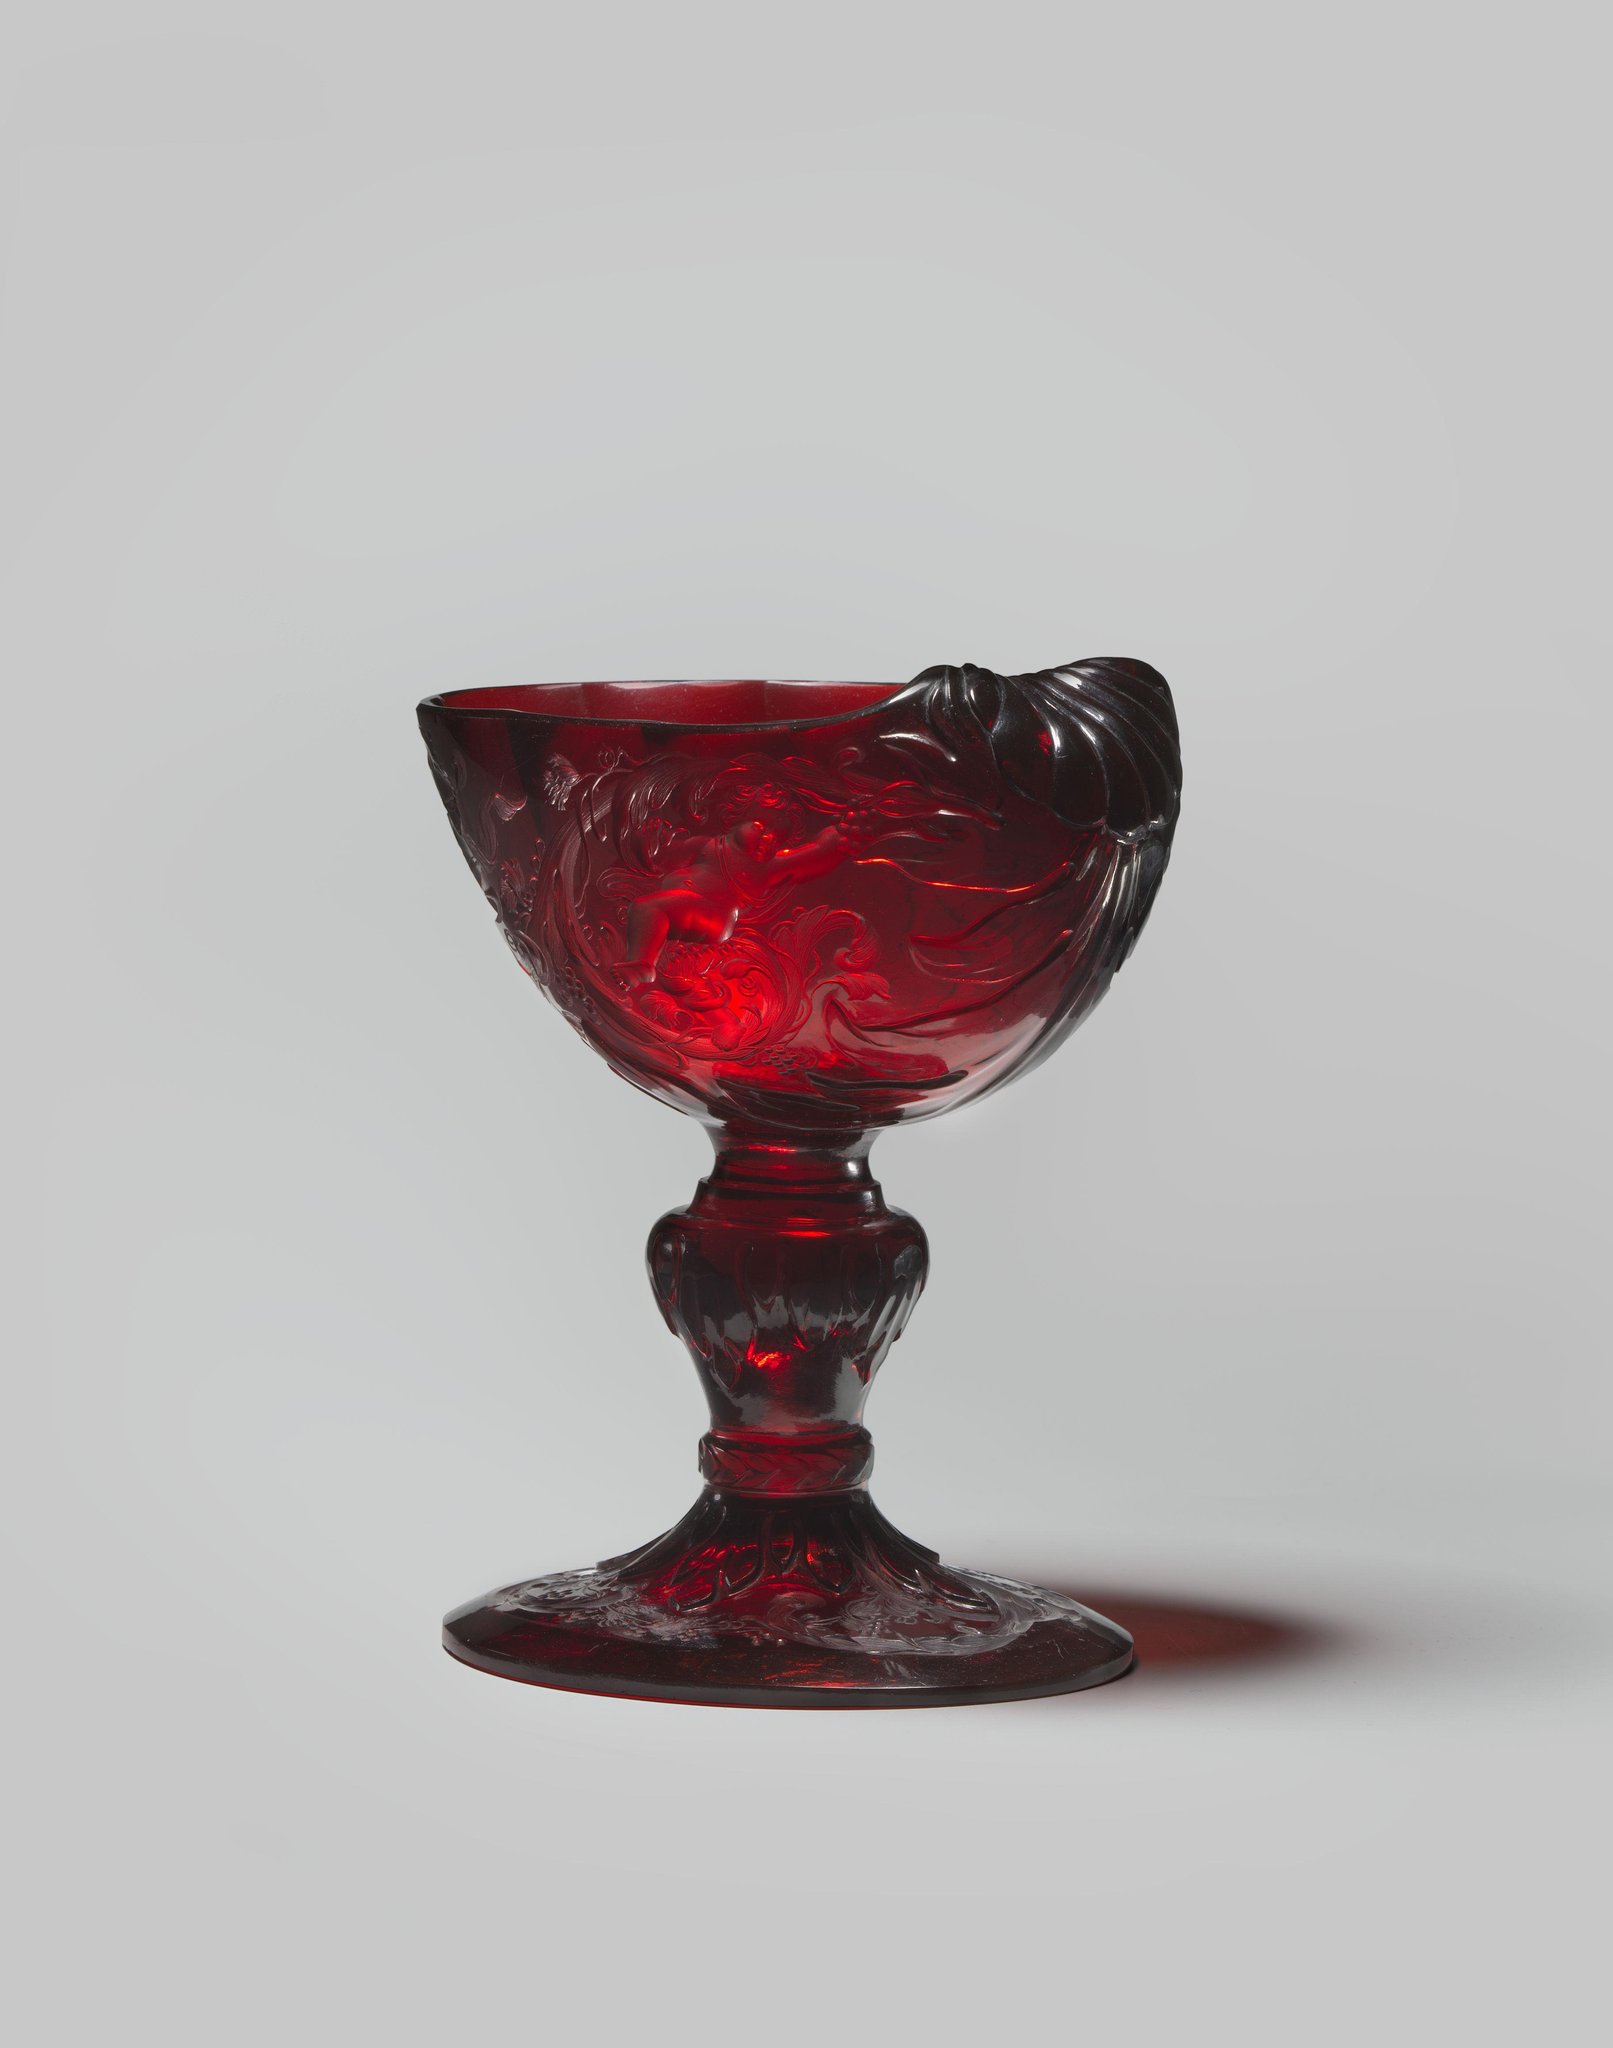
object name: drinking glass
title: Gold Ruby Goblet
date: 1685-1690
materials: glass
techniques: glassblowing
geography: potsdam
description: The red colour of this goblet is due to the addition of tiny gold particles to the glass melt. This process was pioneered by the German alchemist Johann Kunckel in the late 17th century, following which gold ruby glass vessels became hugely sought after. Its allure derived from its colour and from the magical qualities associated with gold and ruby. The glass engraver worked the goblet such that it resembled a cut gemstone rather than mere glass.